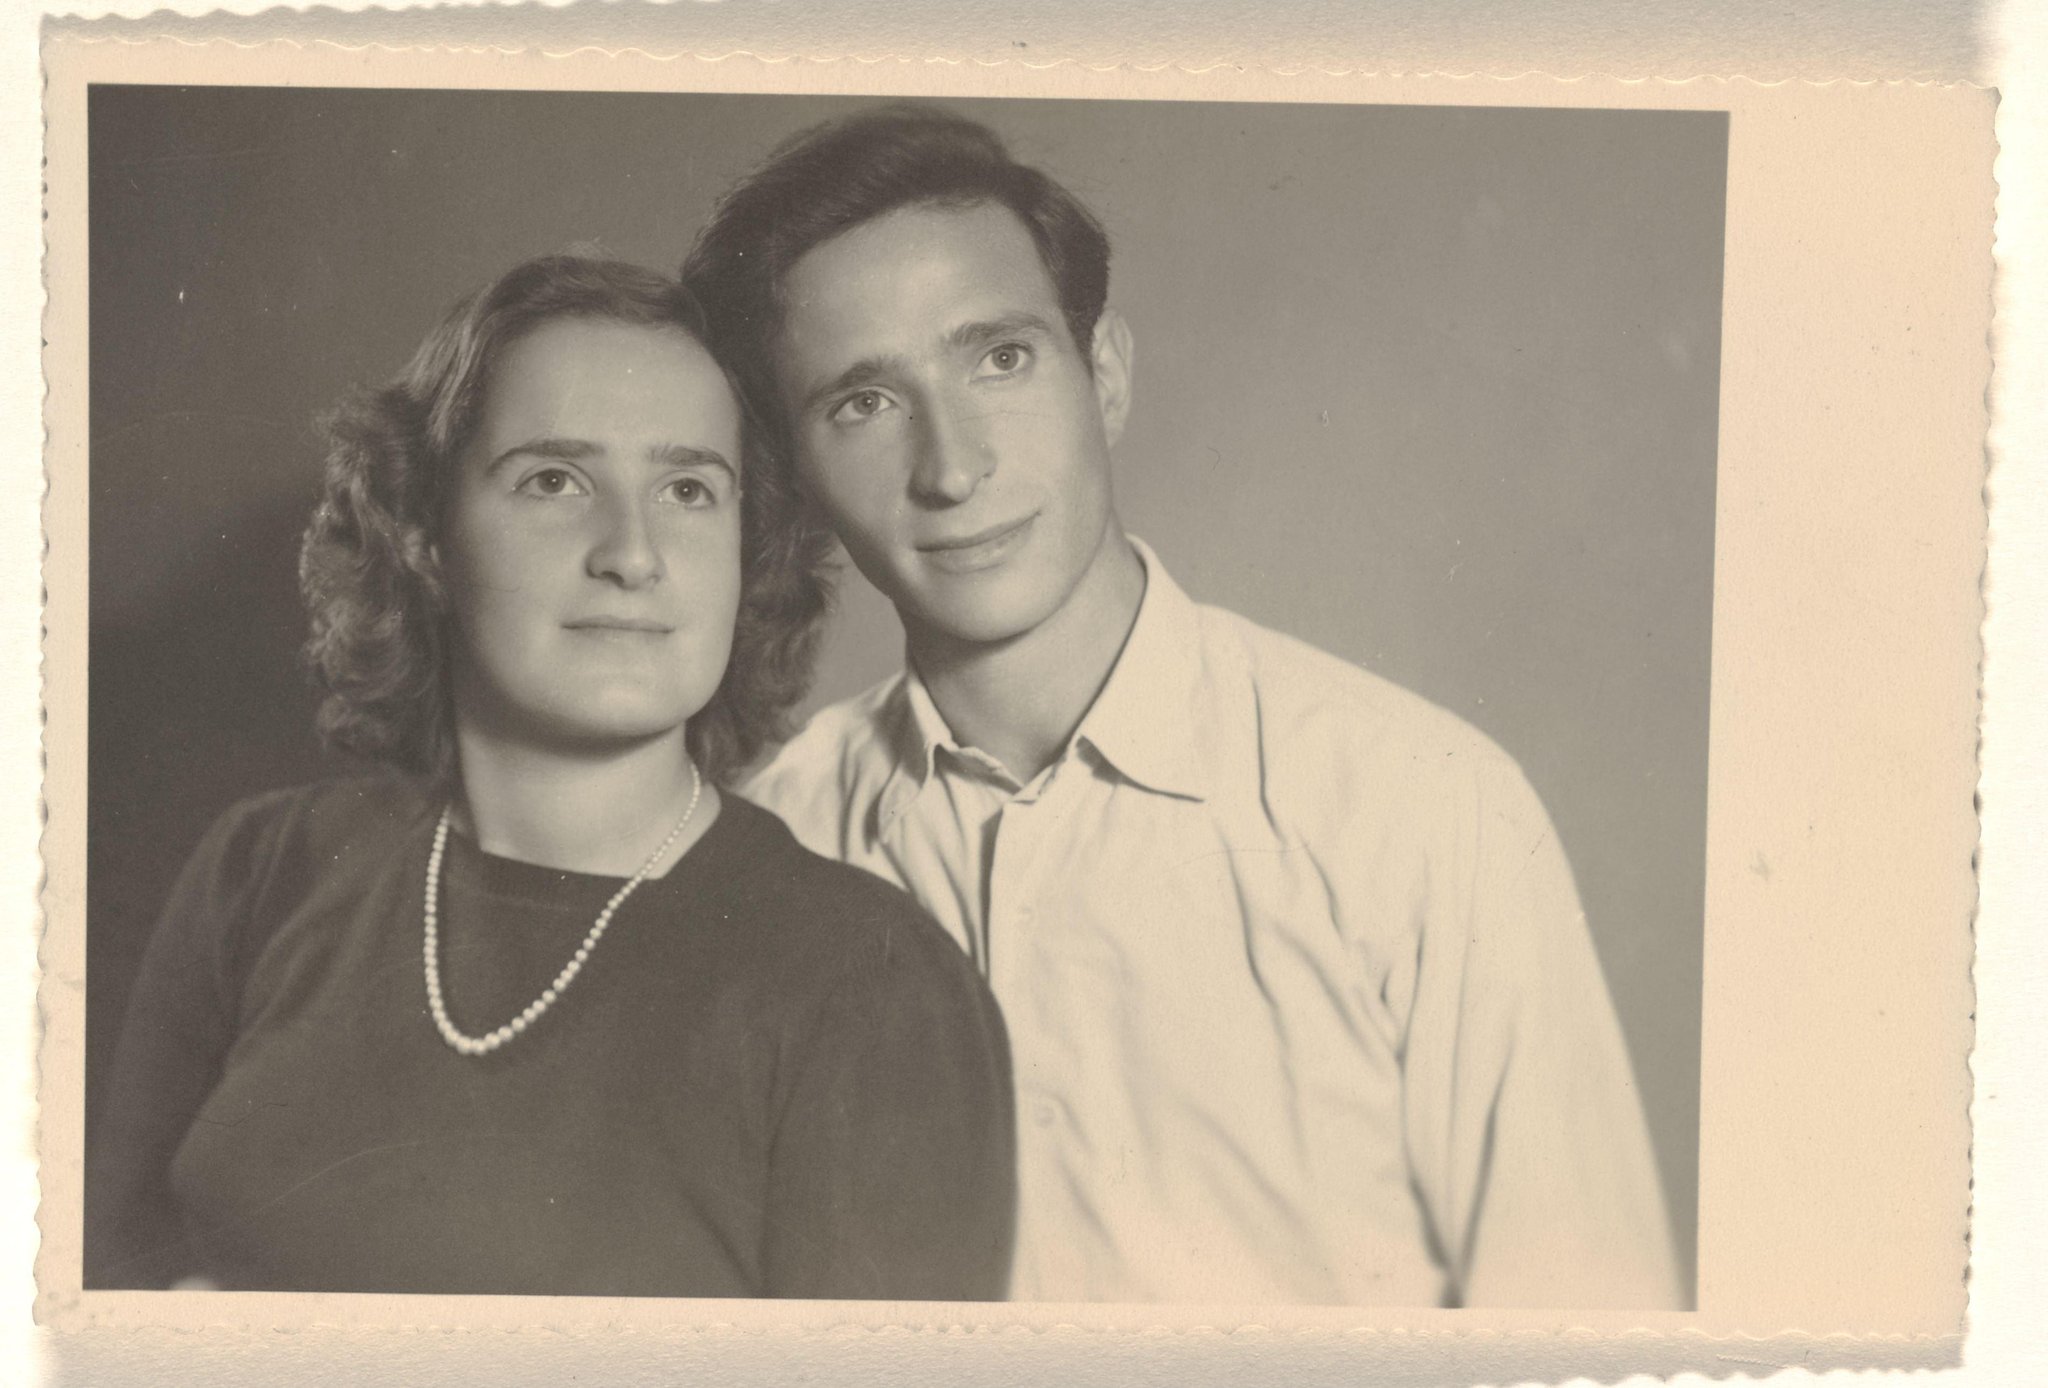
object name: photograph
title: Isabel Wachenheimer in donkere kleding met parelketting om en Leo Blumensohn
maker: Anonymous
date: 1945-1949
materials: photographic support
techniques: gelatin silver print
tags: leiden, isabel wachenheimer-elon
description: Isabel Wachenheimer in donkere kleding met parelketting om en Leo Blumensohn in wit hemd, met het hoofd licht gekanteld en naar voren kijkend.